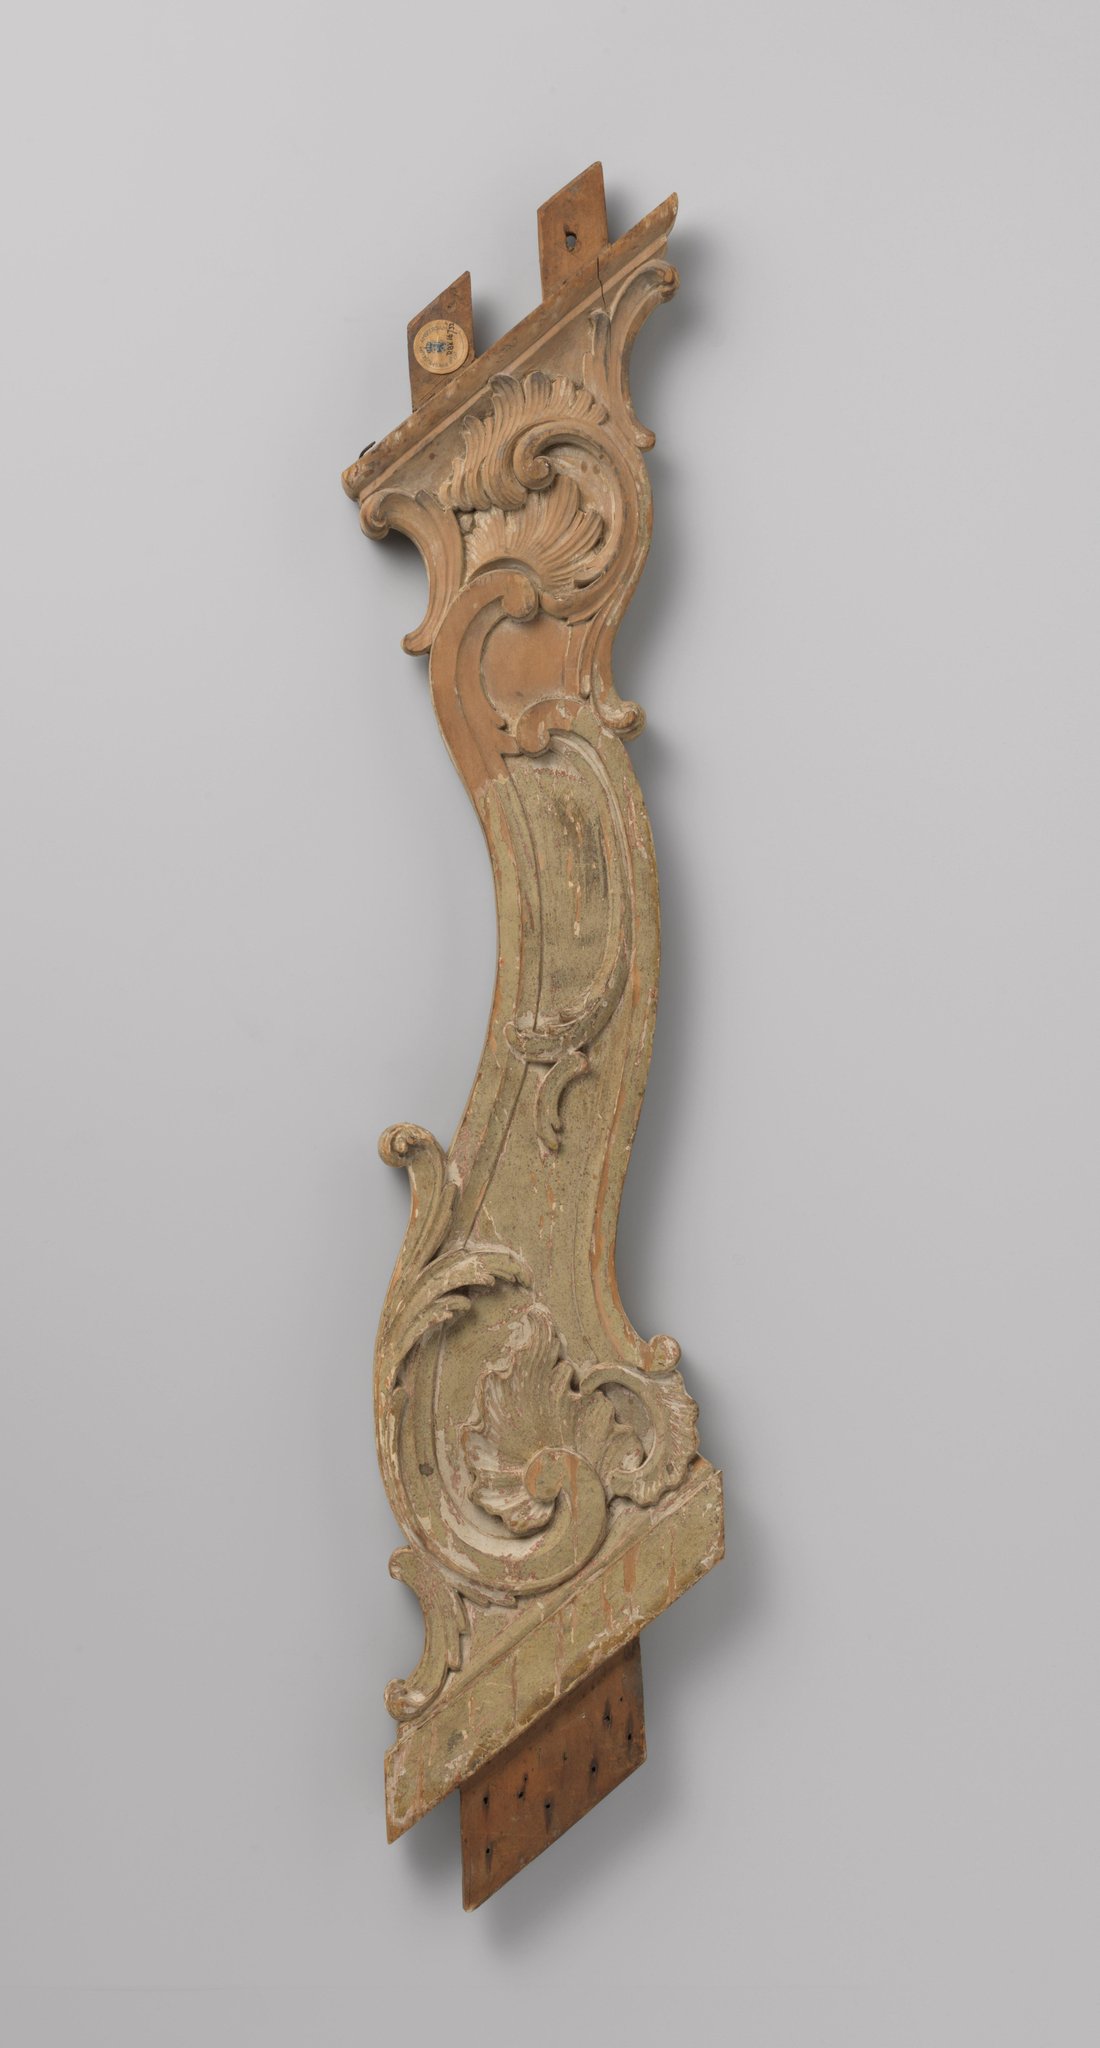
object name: stair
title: Baluster met gestoken C- en S-voluten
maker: Anonymous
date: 1740-1760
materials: wood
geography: northern netherlands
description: S-vormige baluster met gestoken C- en S-voluten met rocaille-schelpen.